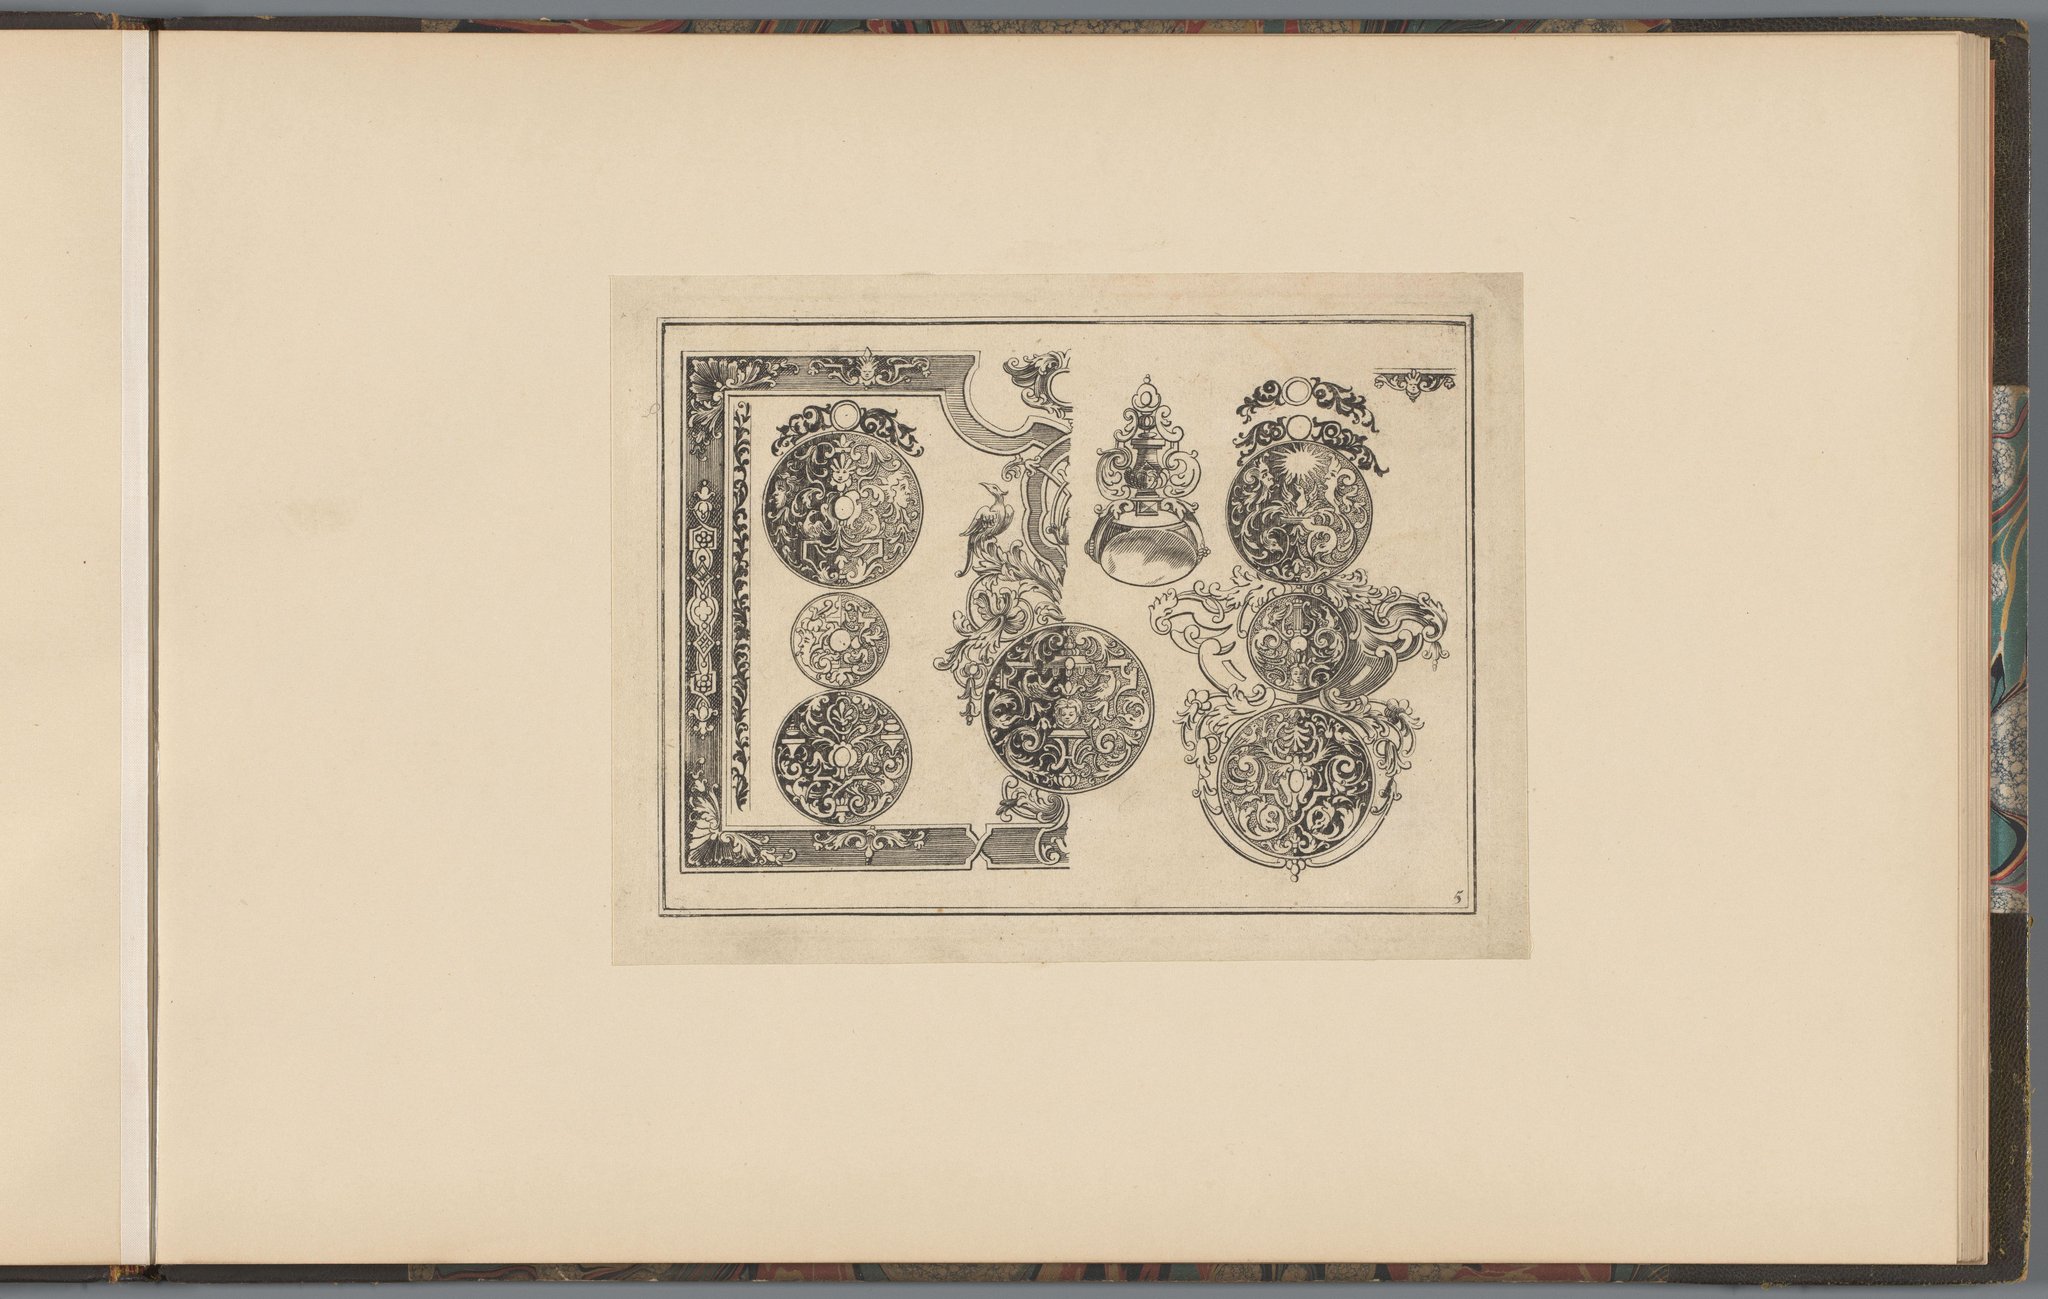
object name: ornament print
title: ontwerpen voor horlogekasten met geornamenteerde rand en vogel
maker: johann lorenz hönnig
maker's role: print maker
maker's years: 1674-1713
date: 1707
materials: paper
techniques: engraving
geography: nuremberg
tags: ornaments ~ art, ribbon, scroll, banderole ~ ornament, watch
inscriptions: number: ‘5’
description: Links een ontwerp voor een horlogekast binnen een geornamenteerde rand met daarbinnen een vogel. De geornamenteerde rand stopt halverwege en rechts nog een ontwerp voor een horlogekast. Zwartornamenten. Prent maakt deel uit van een album.